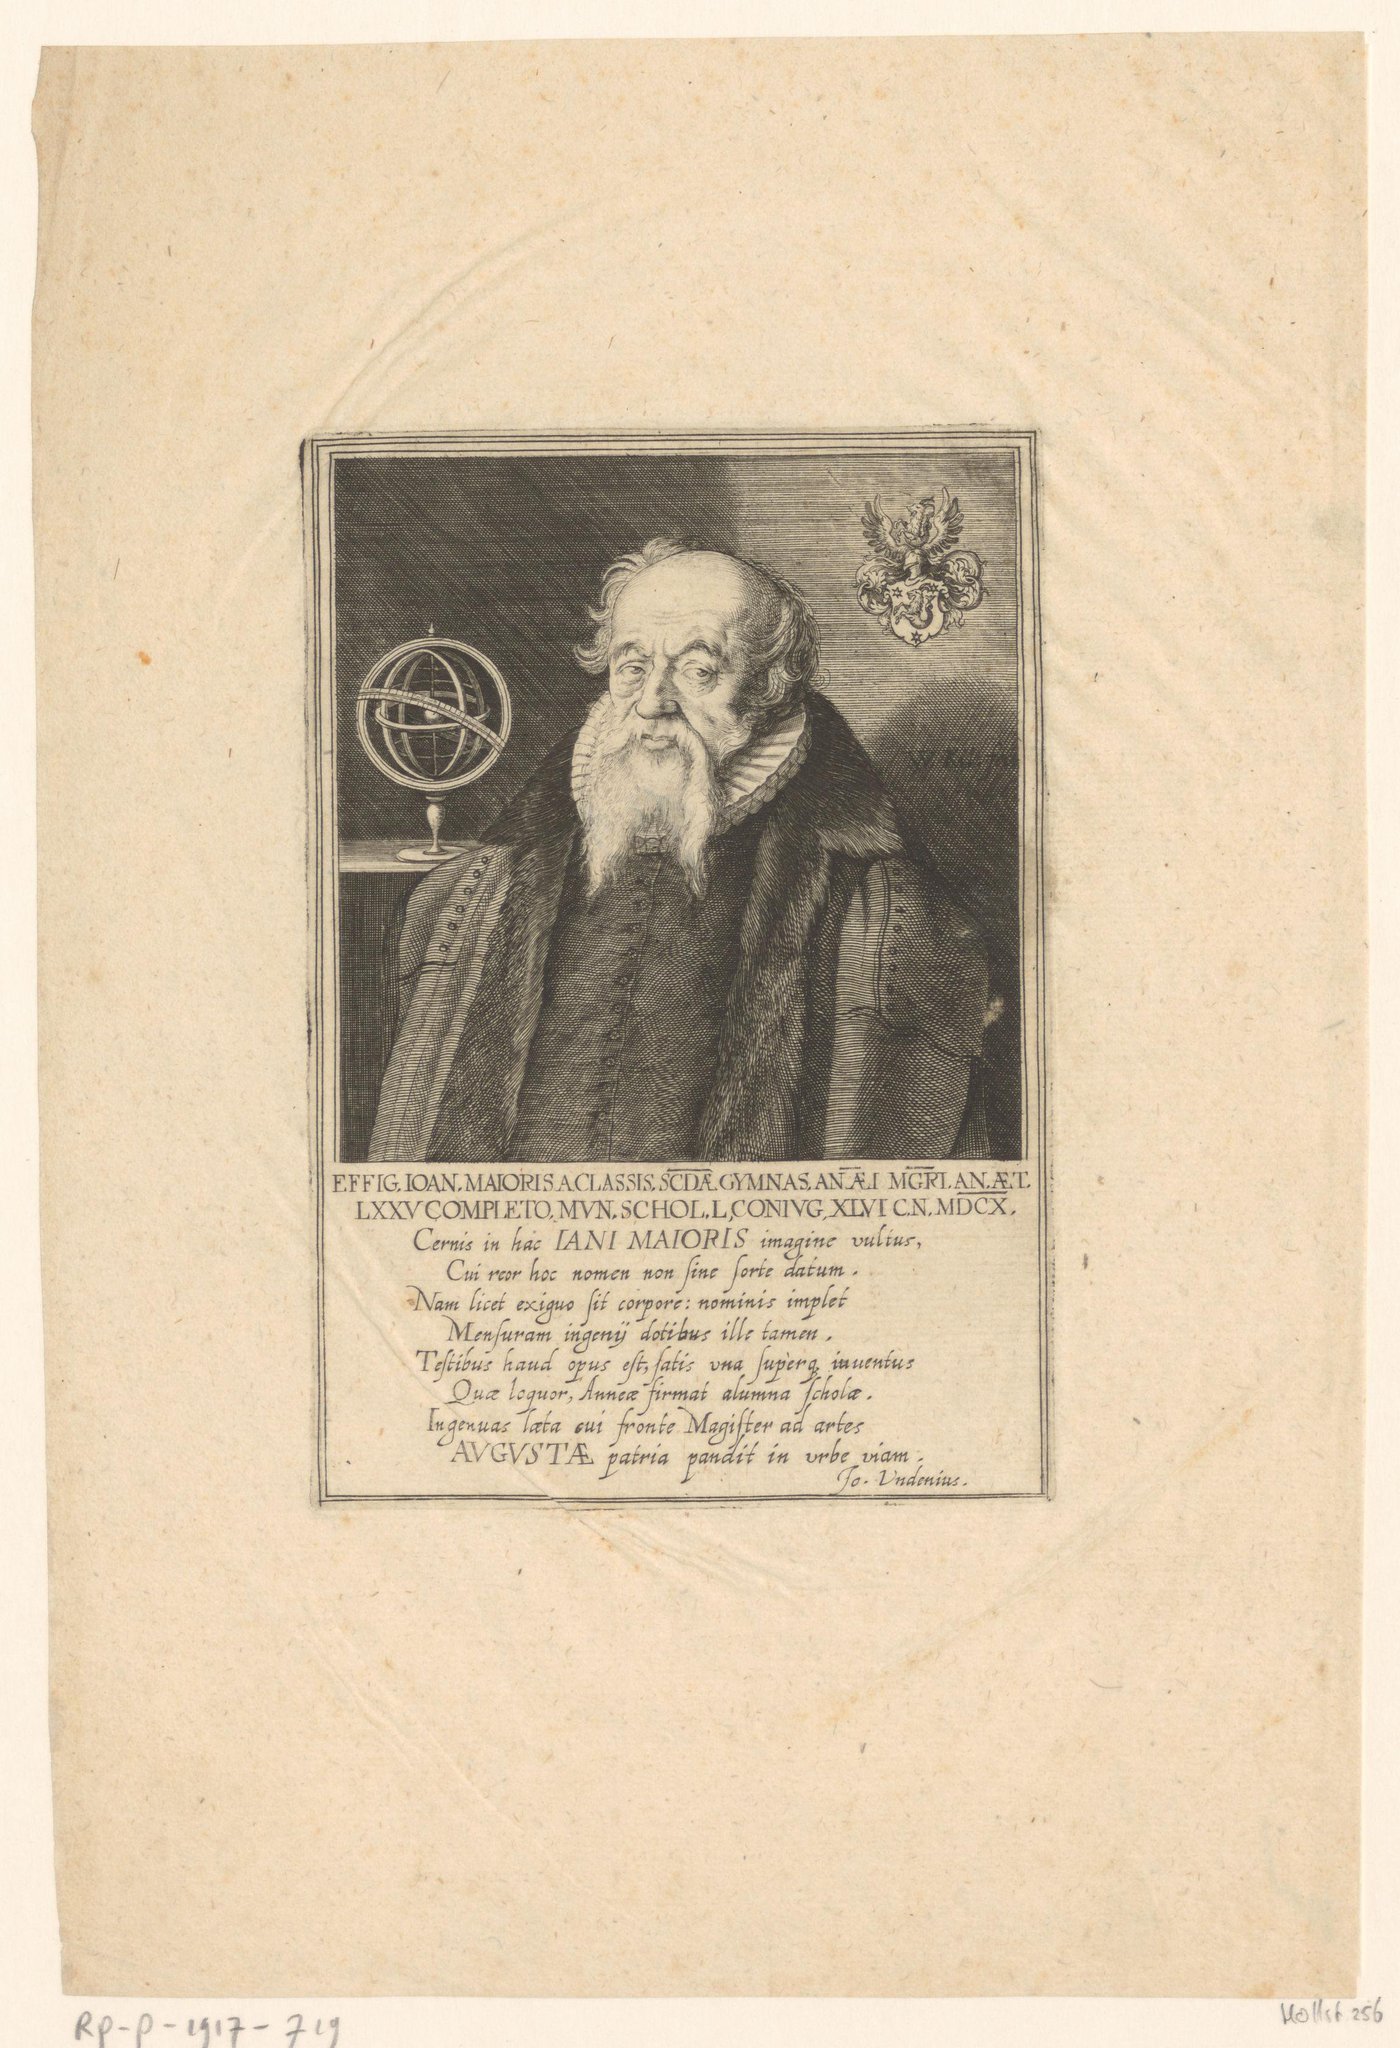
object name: print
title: Portret van Johann Major op 75-jarige leeftijd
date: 1591-1662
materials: paper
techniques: engraving, etching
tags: theologian, historical persons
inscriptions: collector's mark: Lugt 2228